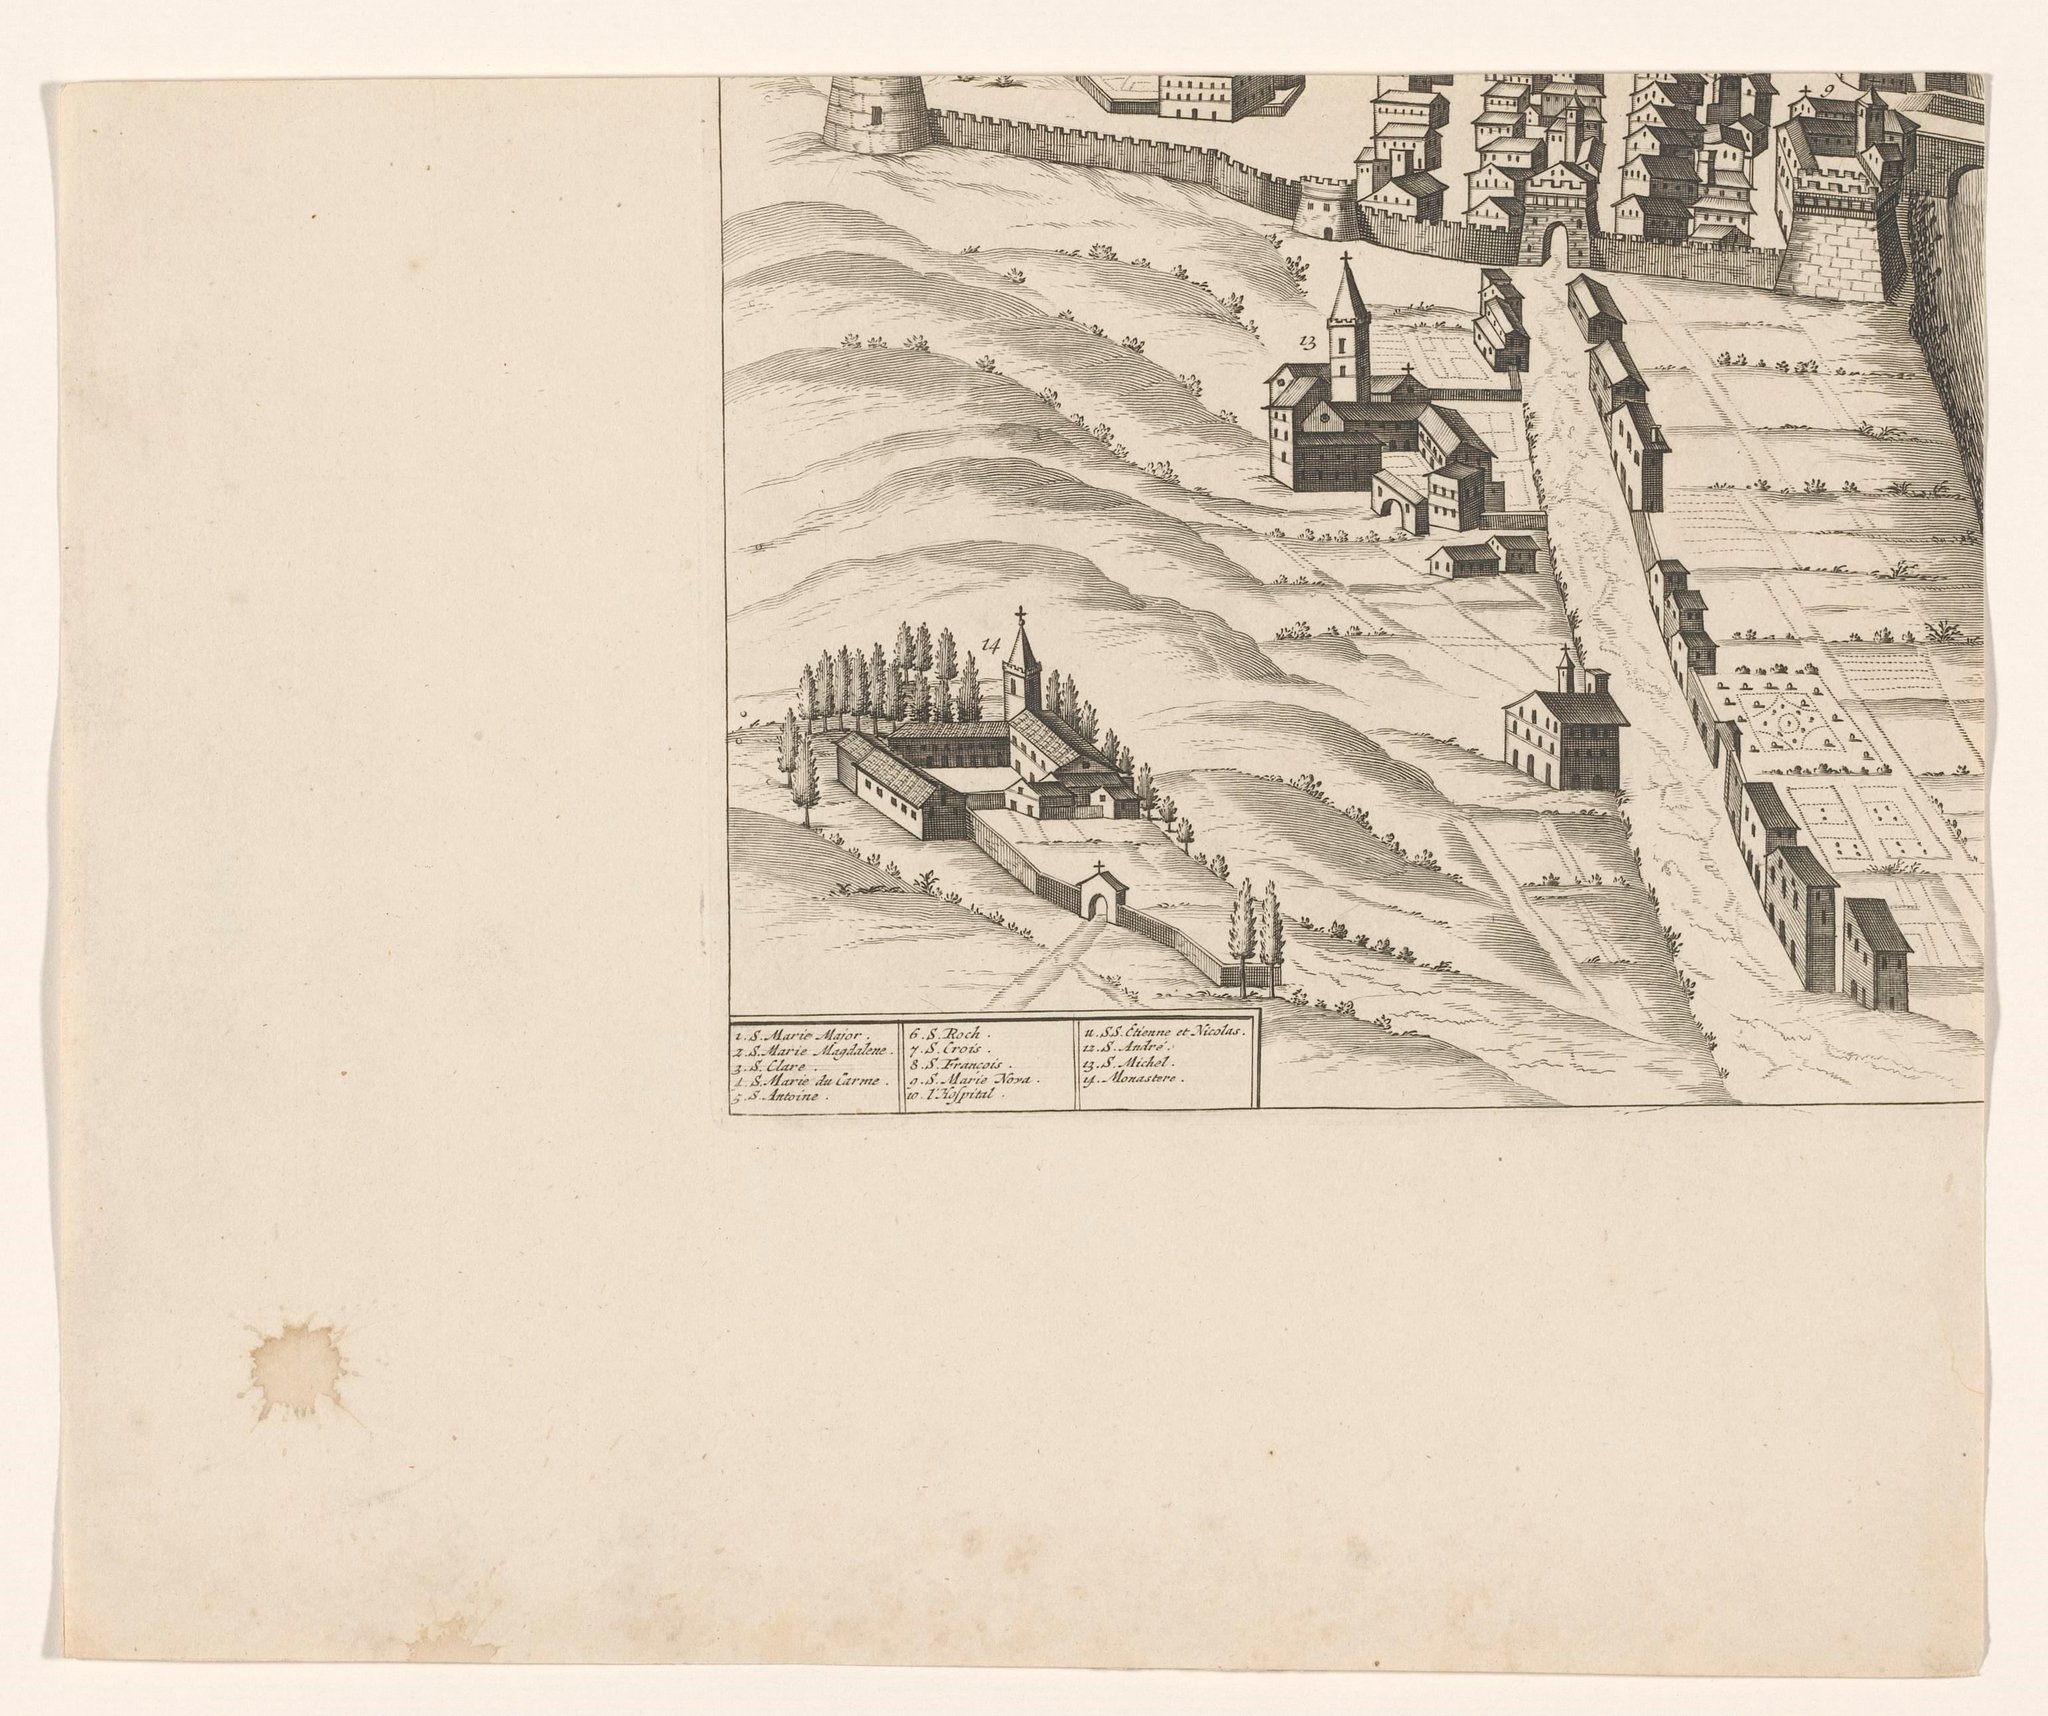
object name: print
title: Plattegrond van een Italiaanse stad (deel linksonder)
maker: Anonymous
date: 1600-1699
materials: paper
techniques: engraving, etching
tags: maps of cities, prospect of city, town panorama, silhouette of city, italy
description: Plattegrond van een Italiaanse stad, gesneden in vier delen. Op het deel linksboven het wapen van de' Medici.